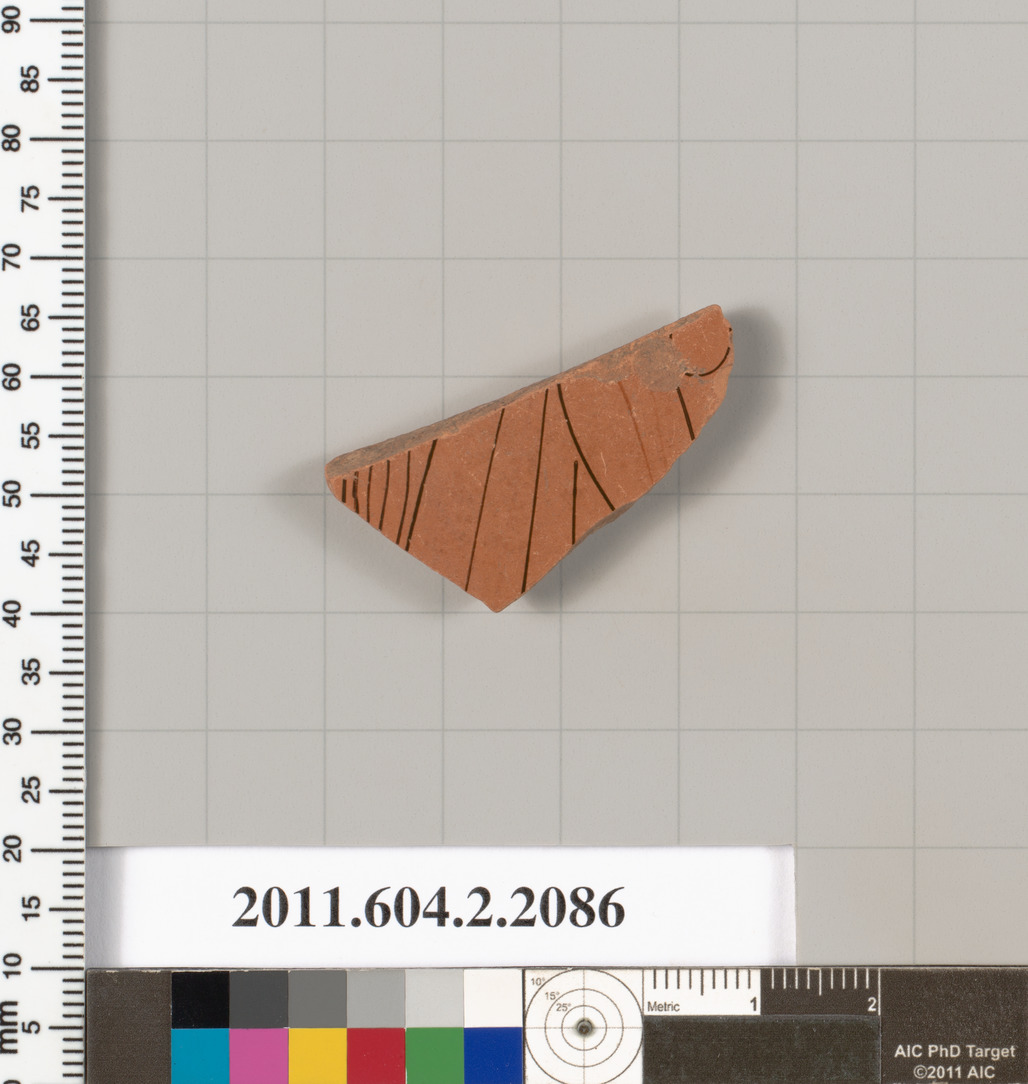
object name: pot fragment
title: Terracotta fragment of a pot; glazed on the inside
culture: greek, attic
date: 475-451 BCE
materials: terracotta